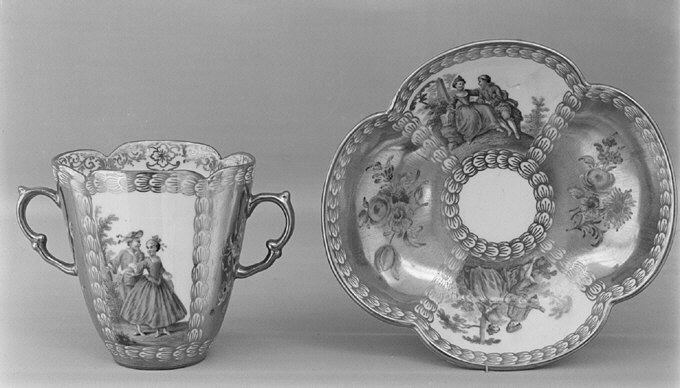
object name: saucer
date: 1801-1900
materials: hard paste porcelain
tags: couples,men,women